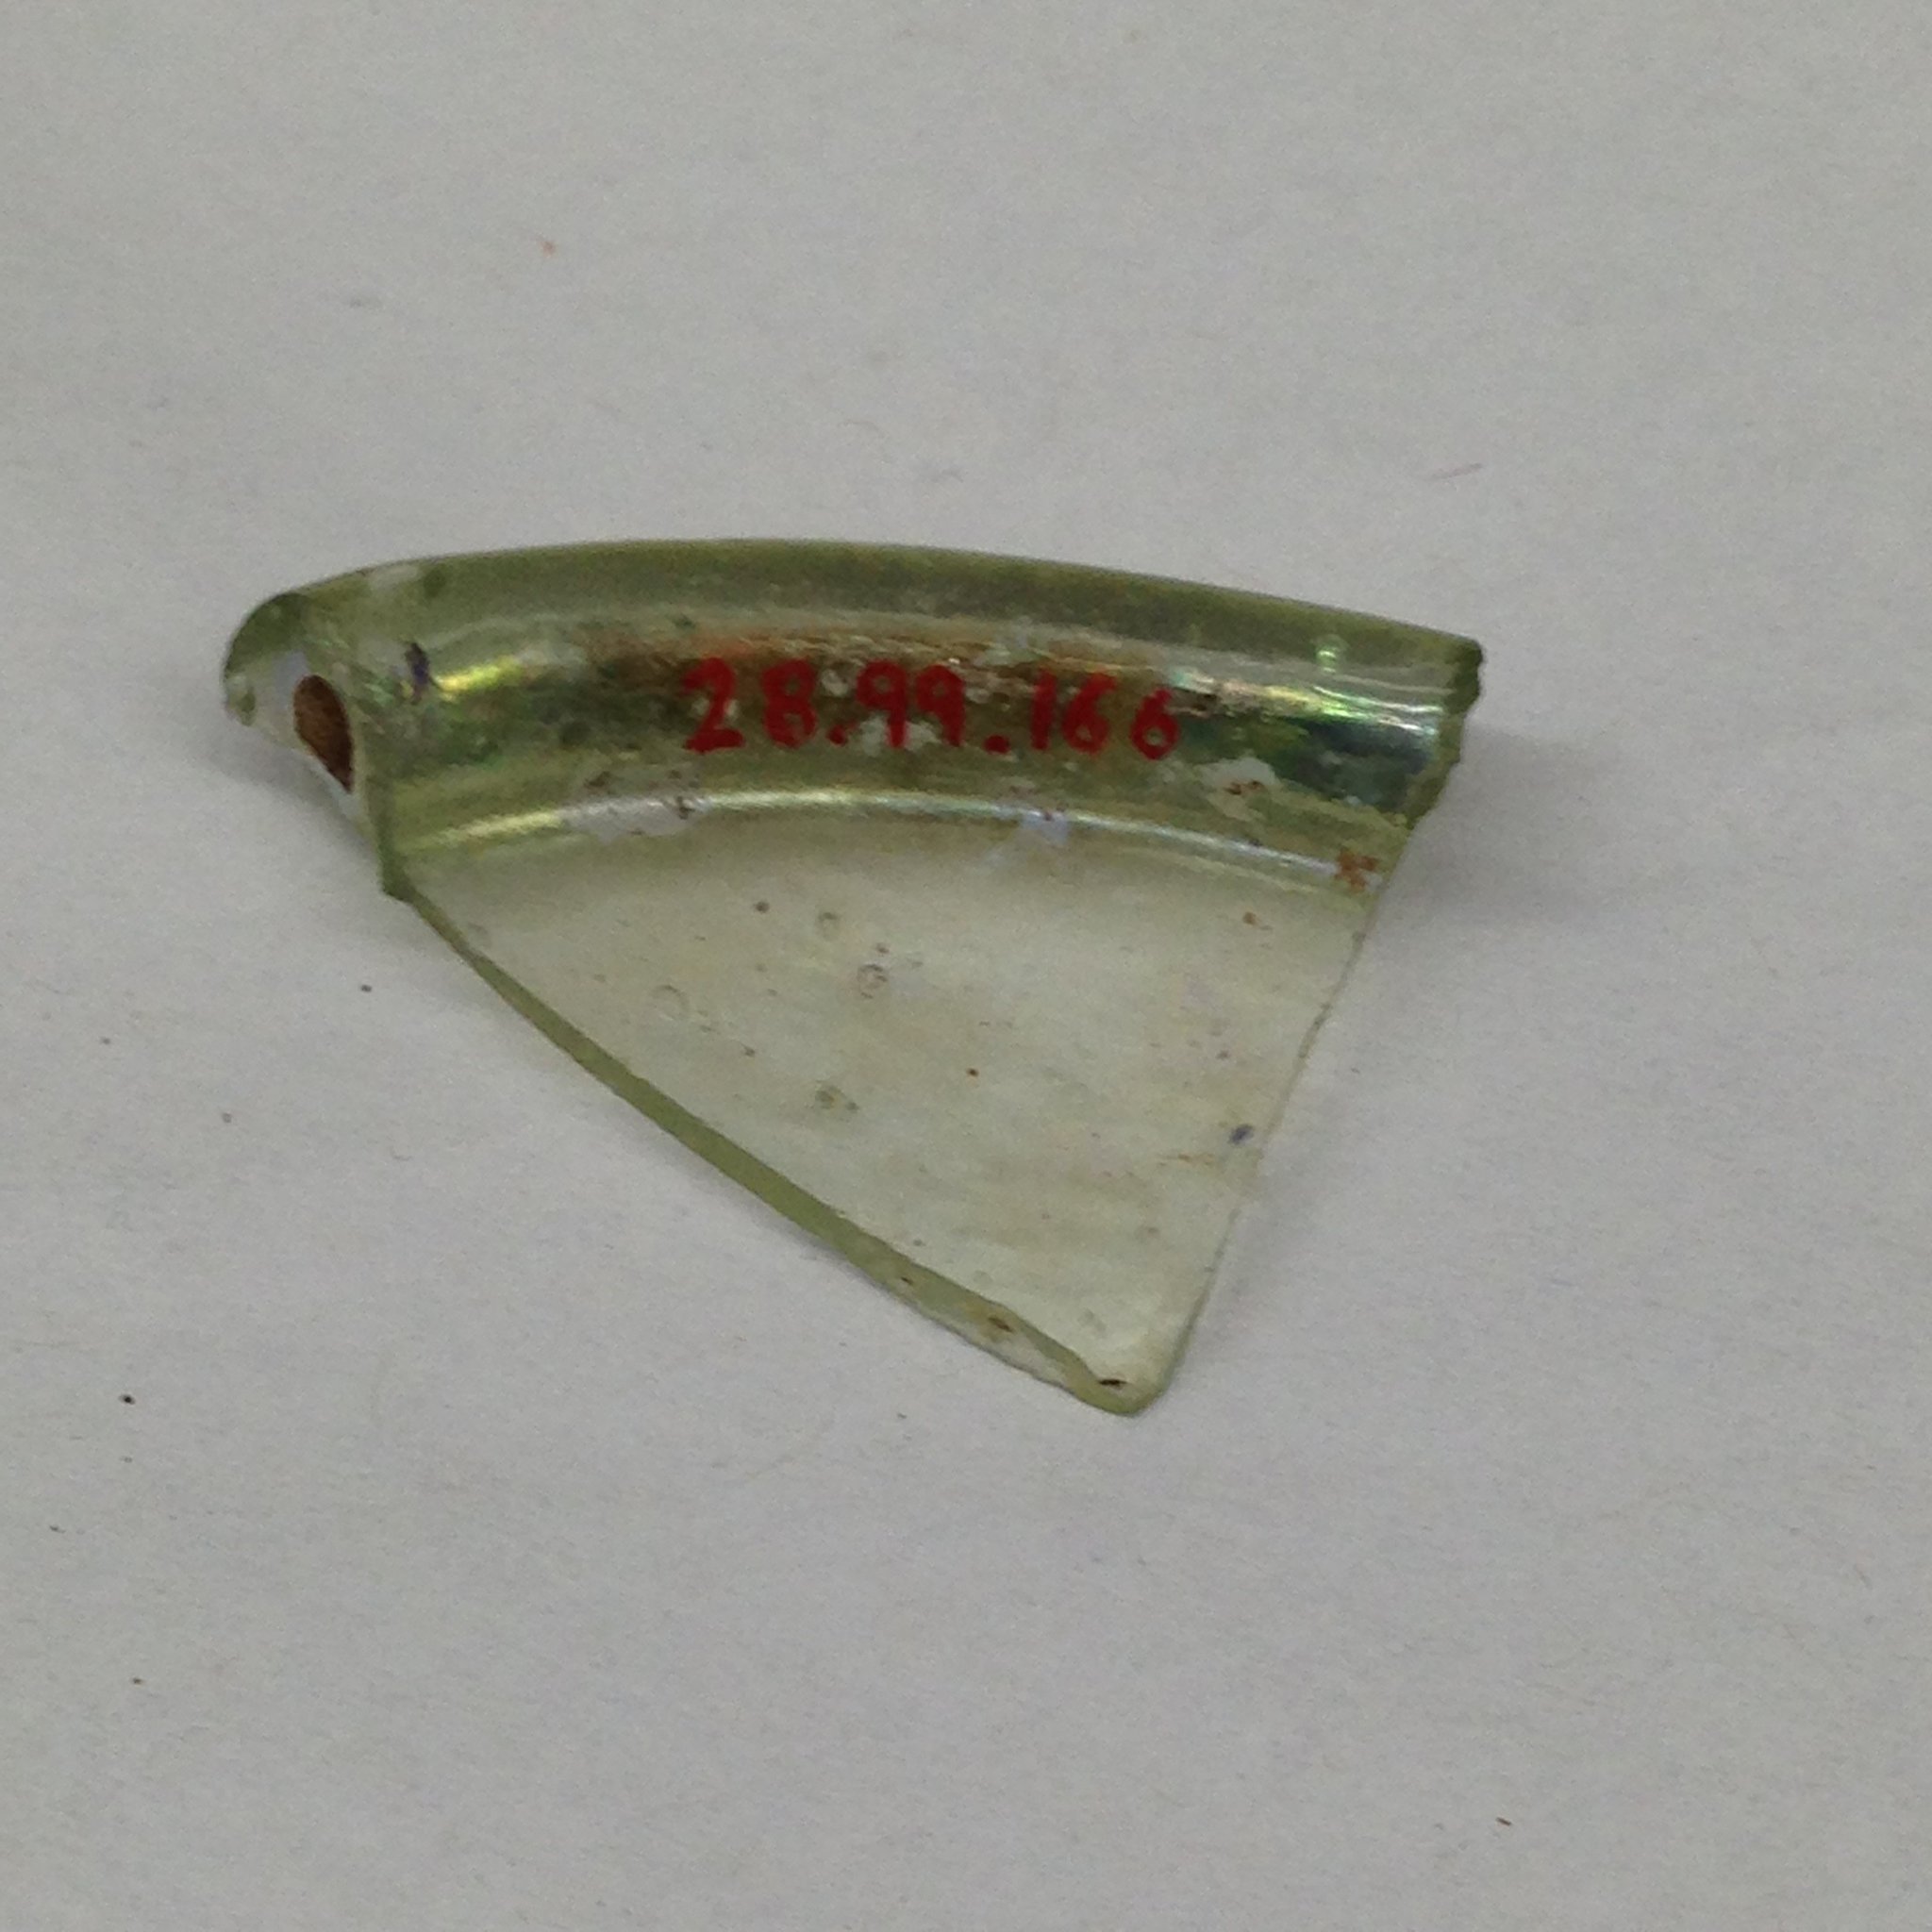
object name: fragment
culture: european or middle eastern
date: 1150-1250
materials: ceramic, glass